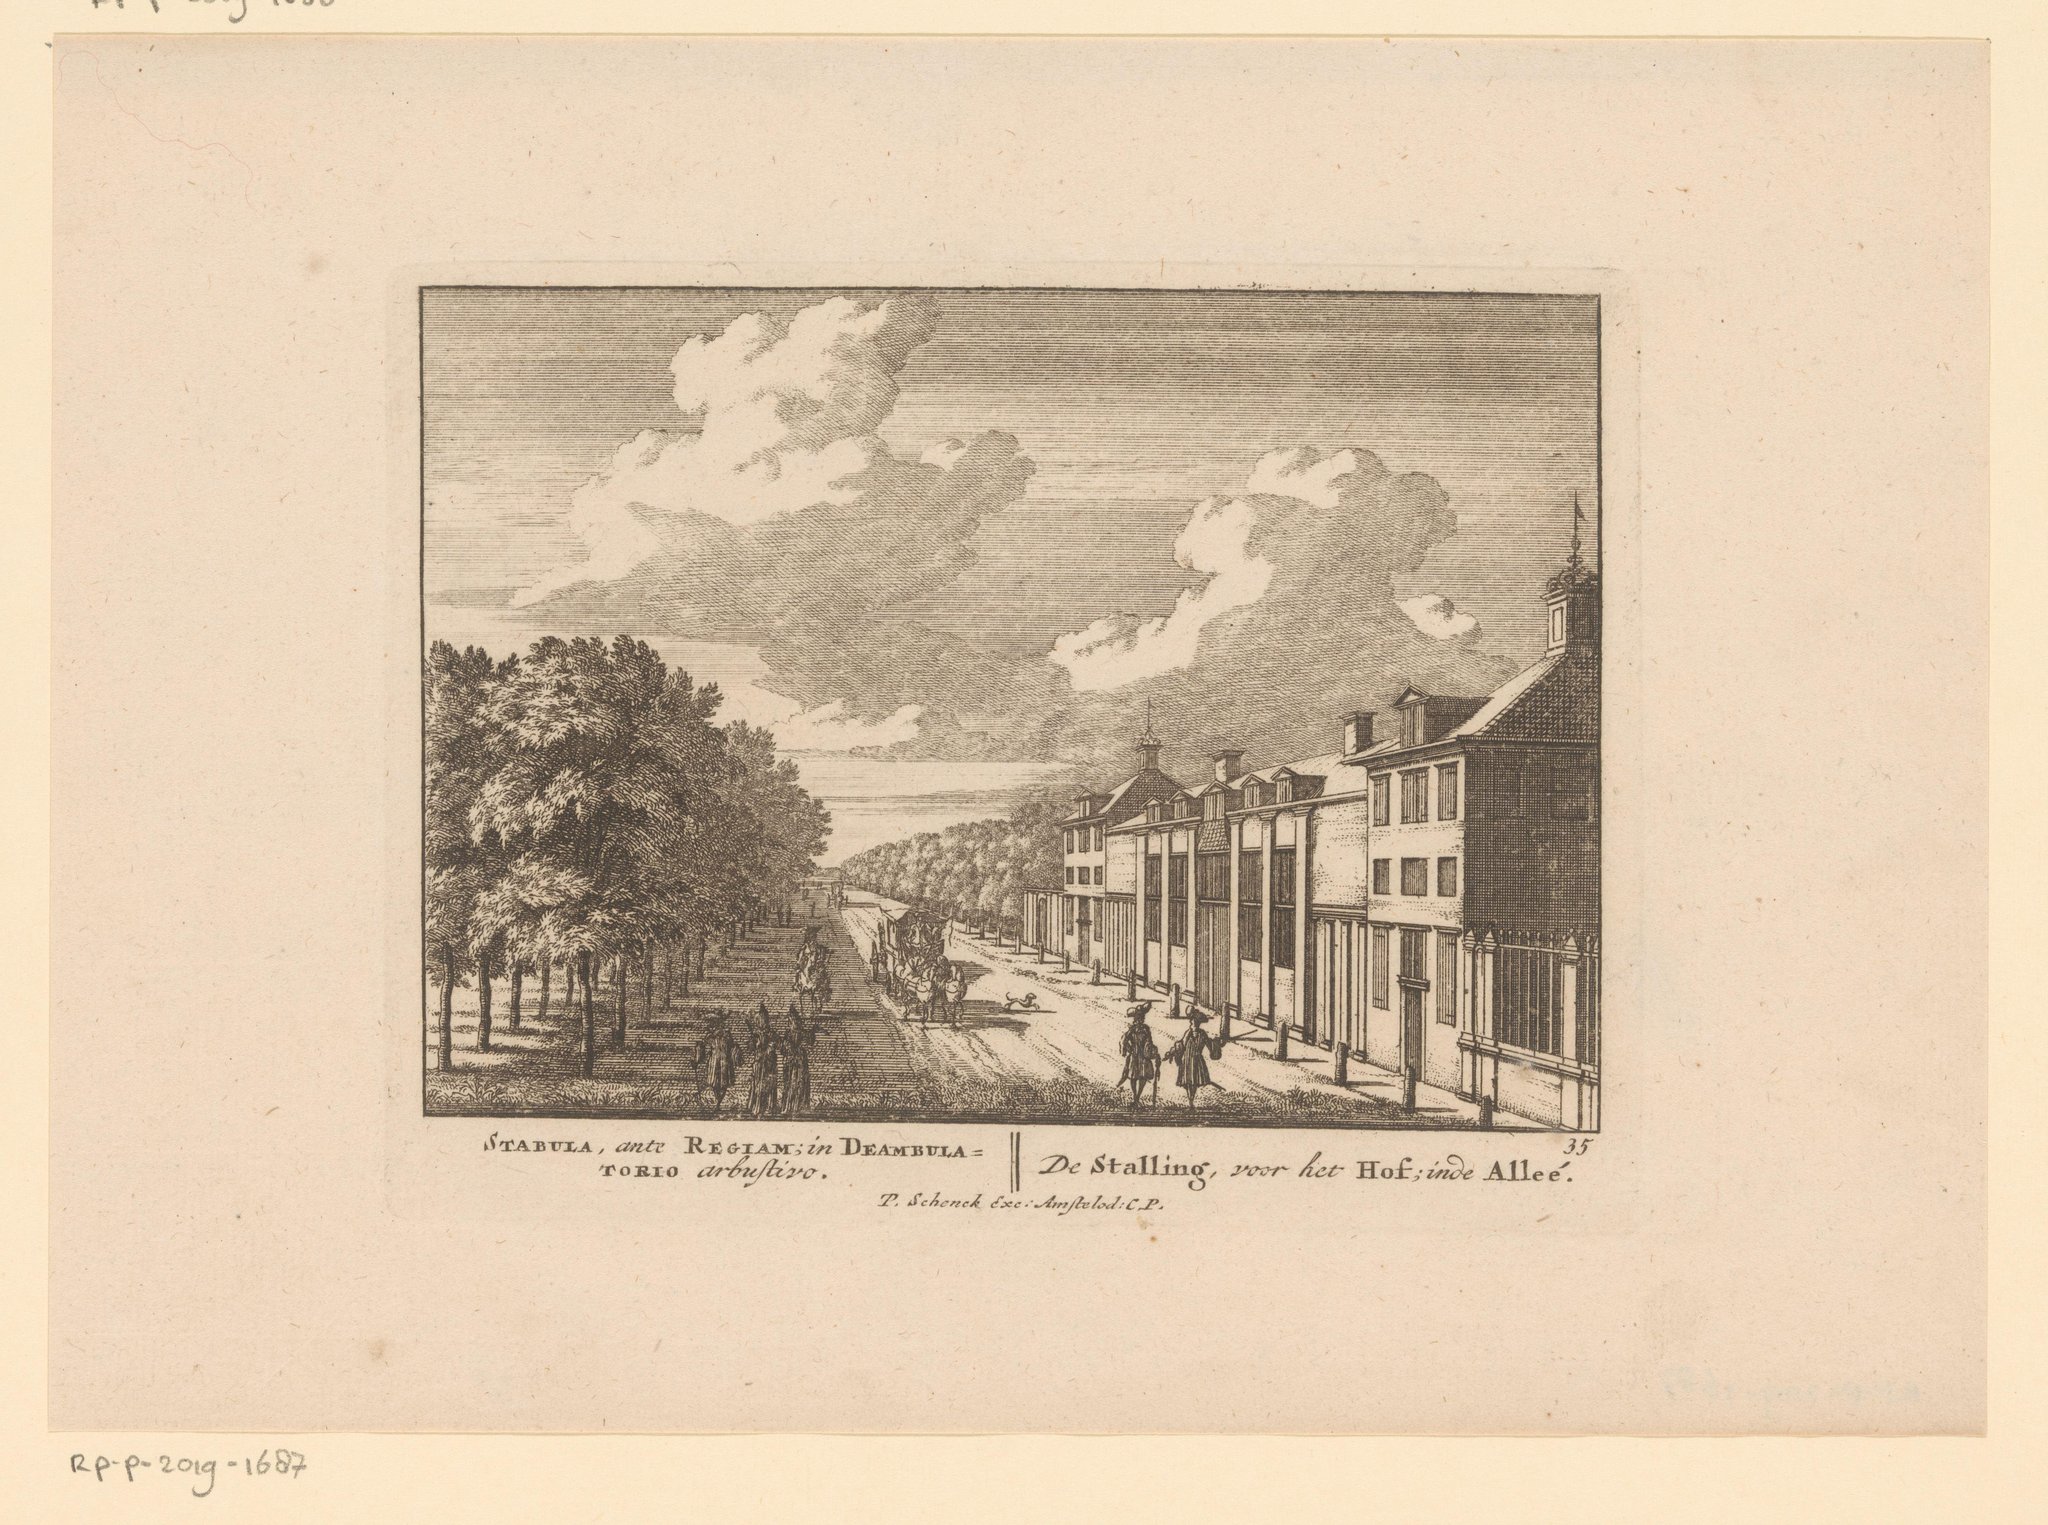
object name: print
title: Admirandorum Quadruplex Spectaculum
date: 1700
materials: paper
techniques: etching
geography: amsterdam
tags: stall, stable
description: Andere staat ook gebruikt in: Call, Jan van. Admirandorum Quadruplex Spectaculum. Amsterdam: Pieter Schenk (I), [1700].* * De titelprent, opdracht en het portret van Frederik van Saksen zijn gegraveerd door Pieter Schenk (I). De overige prenten uit deze serie zijn, zoals aangegeven op de titelprent, van de hand van Jan van Call (I).